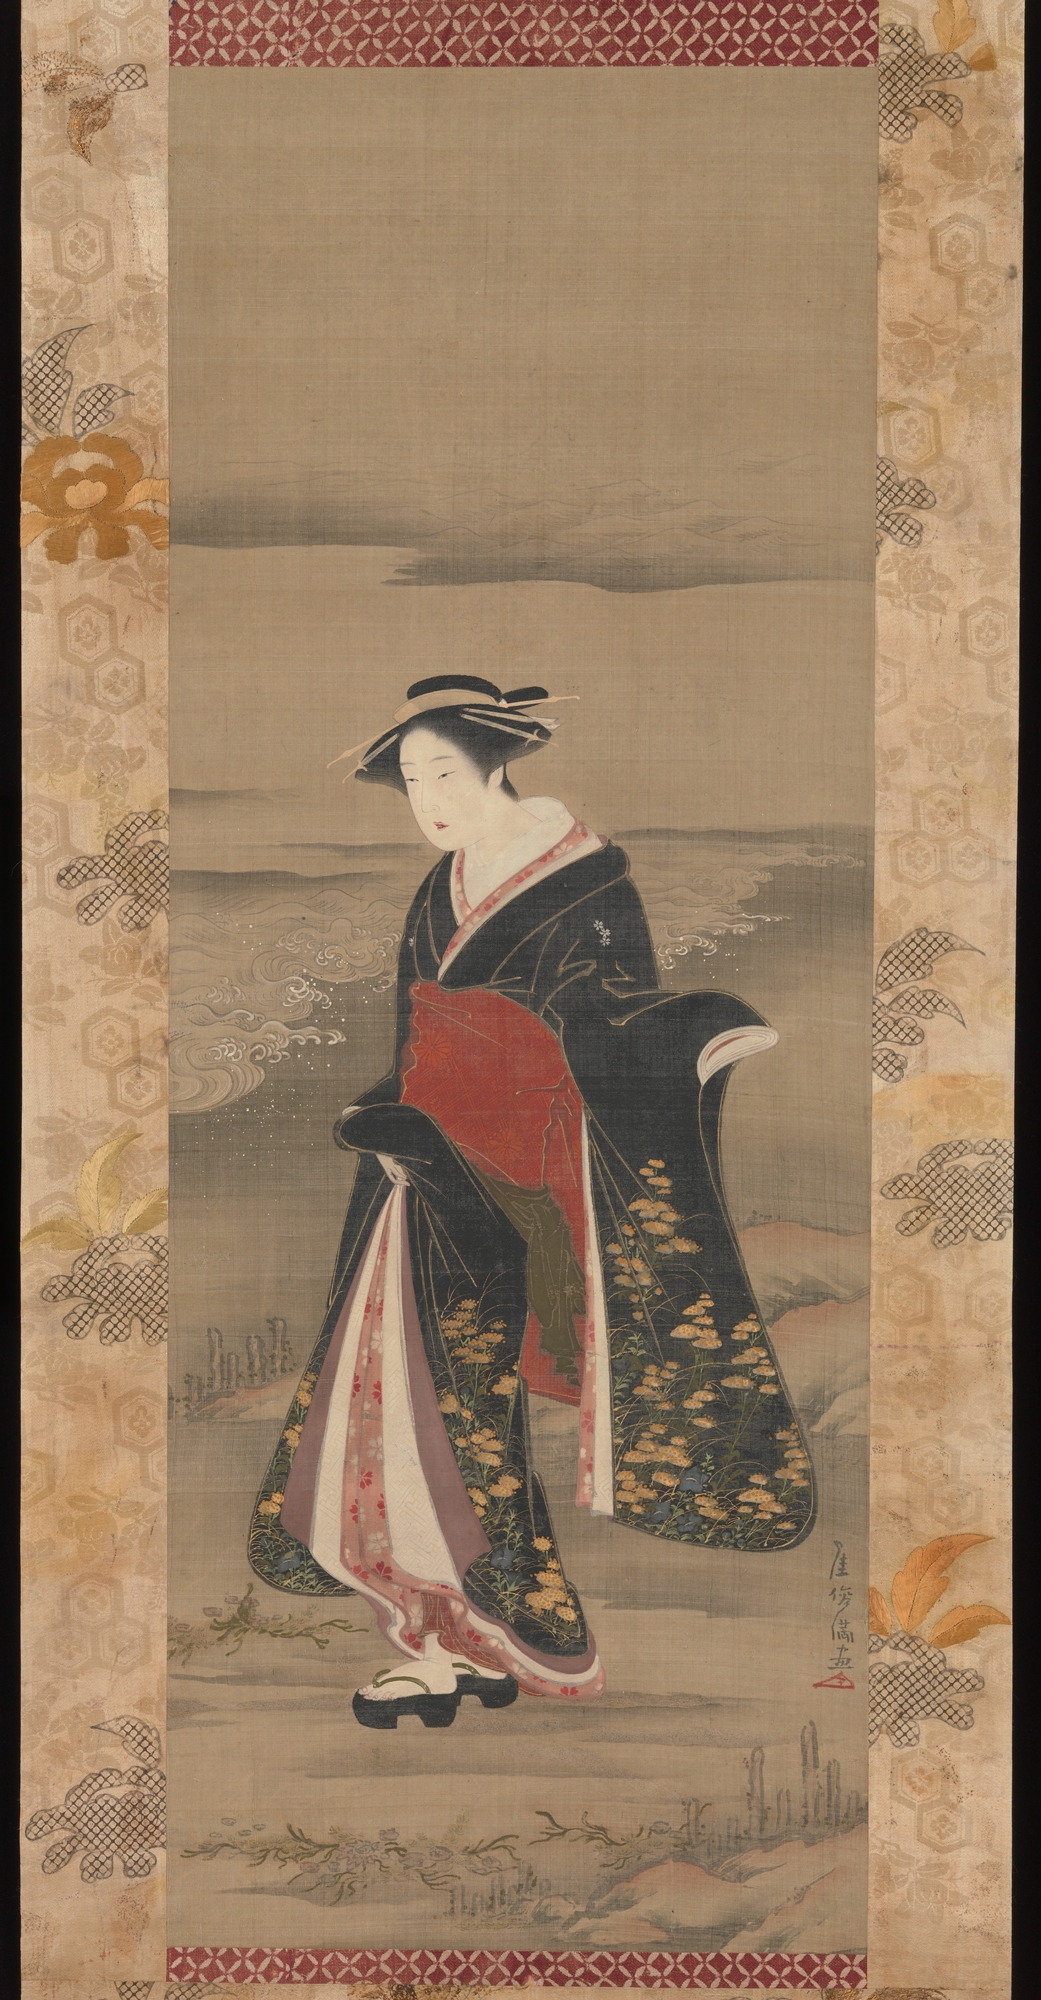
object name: hanging scroll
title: Beauty by the Shore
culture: japanese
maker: kubo shunman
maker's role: artist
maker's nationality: japanese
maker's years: 1757-1820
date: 1767-1800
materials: ink, paper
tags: women